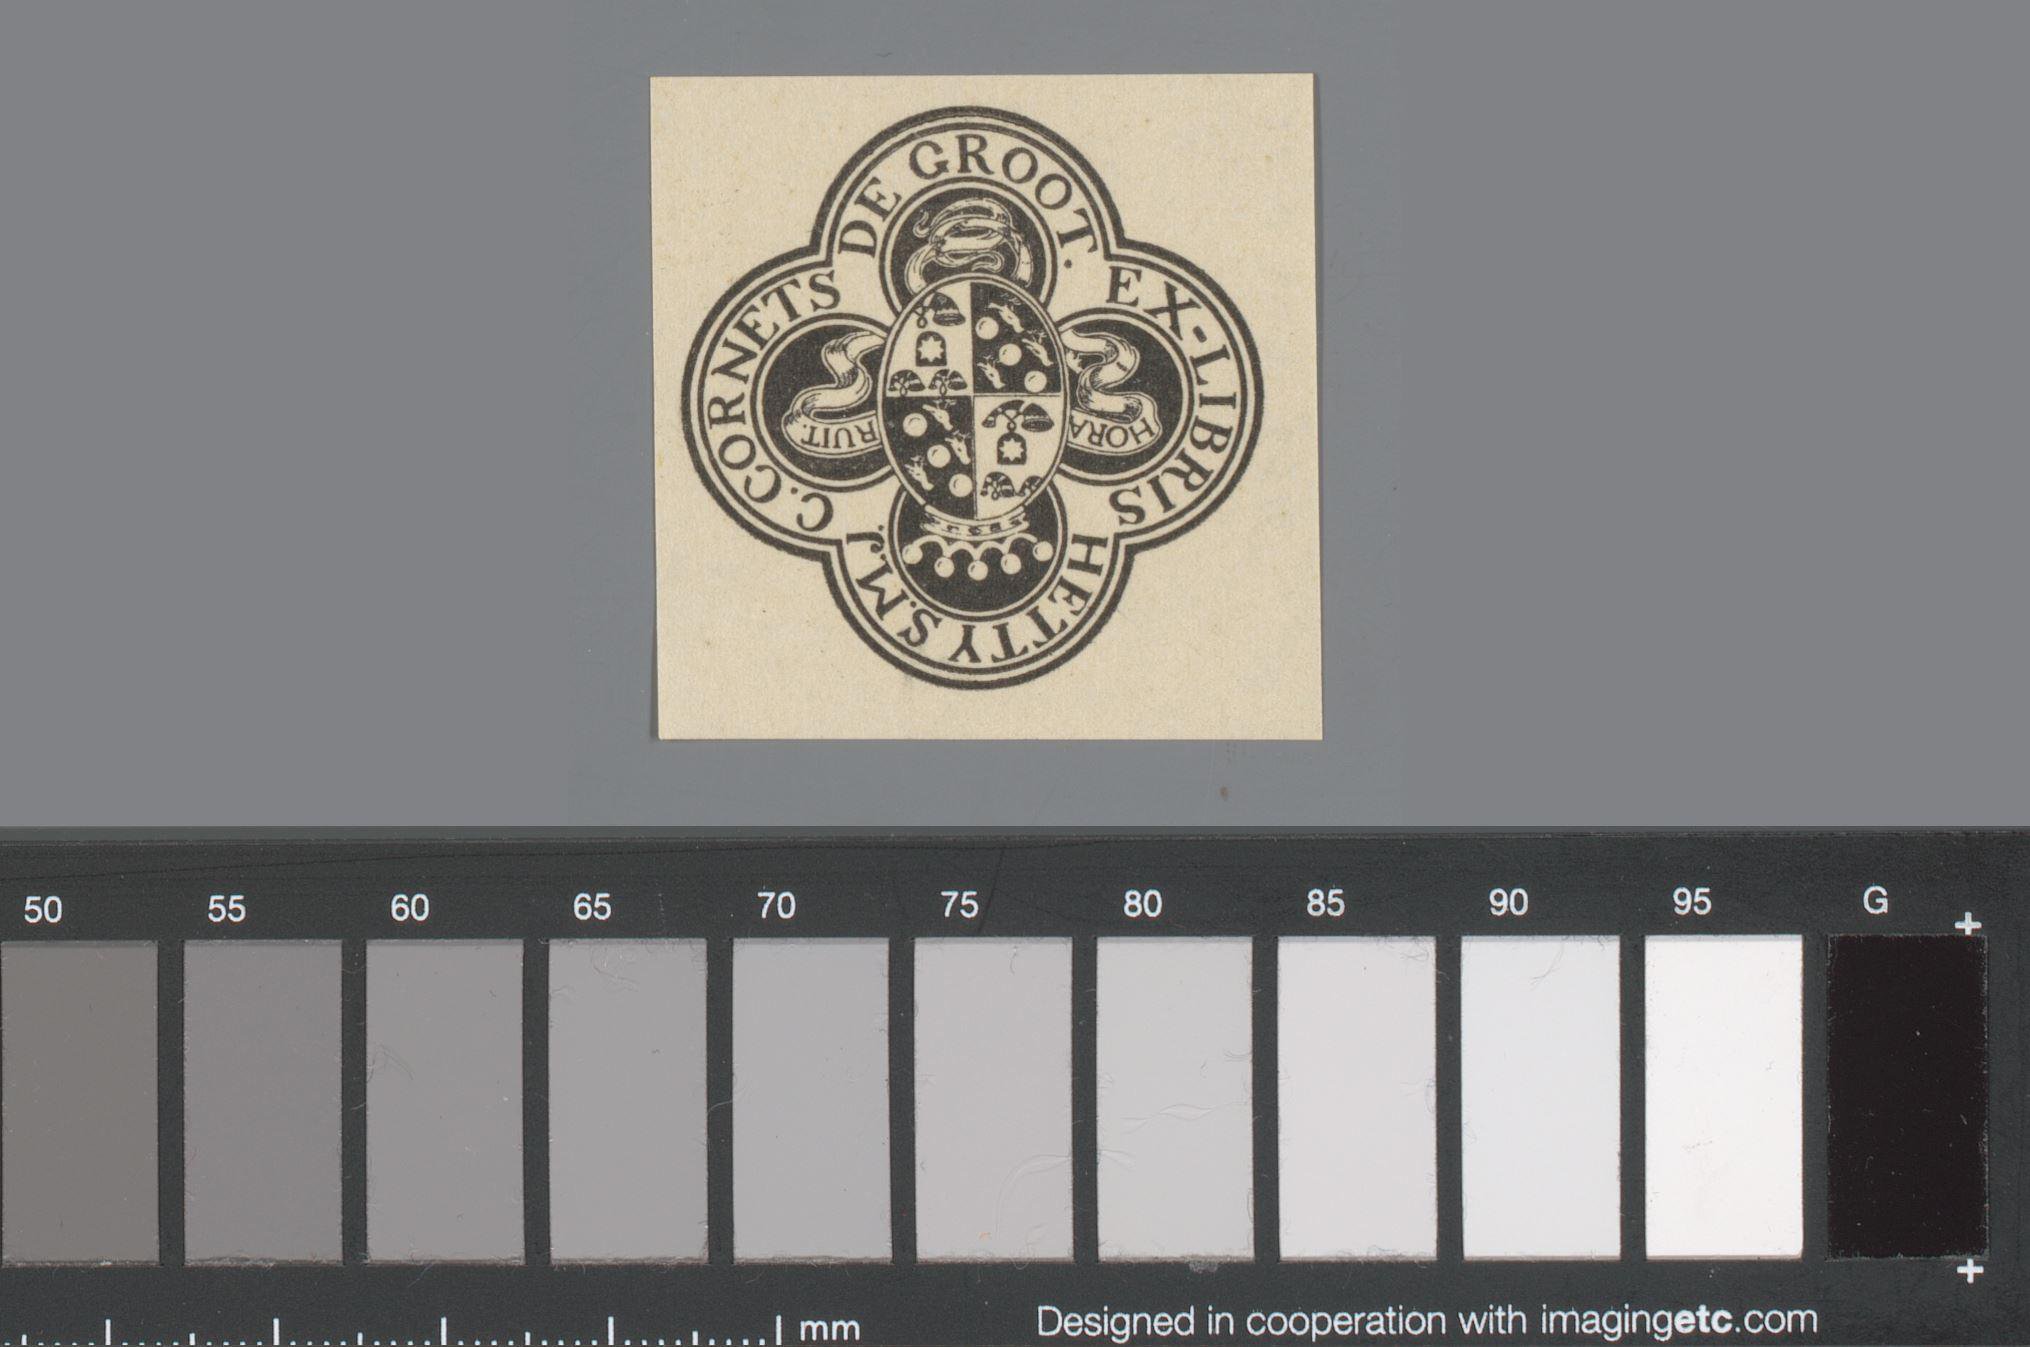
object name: bookplate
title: Ex libris van Hetty S.M.J.C. Cornets de Groot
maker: Anonymous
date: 1886-1948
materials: paper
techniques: printing block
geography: netherlands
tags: armorial bearing, heraldry